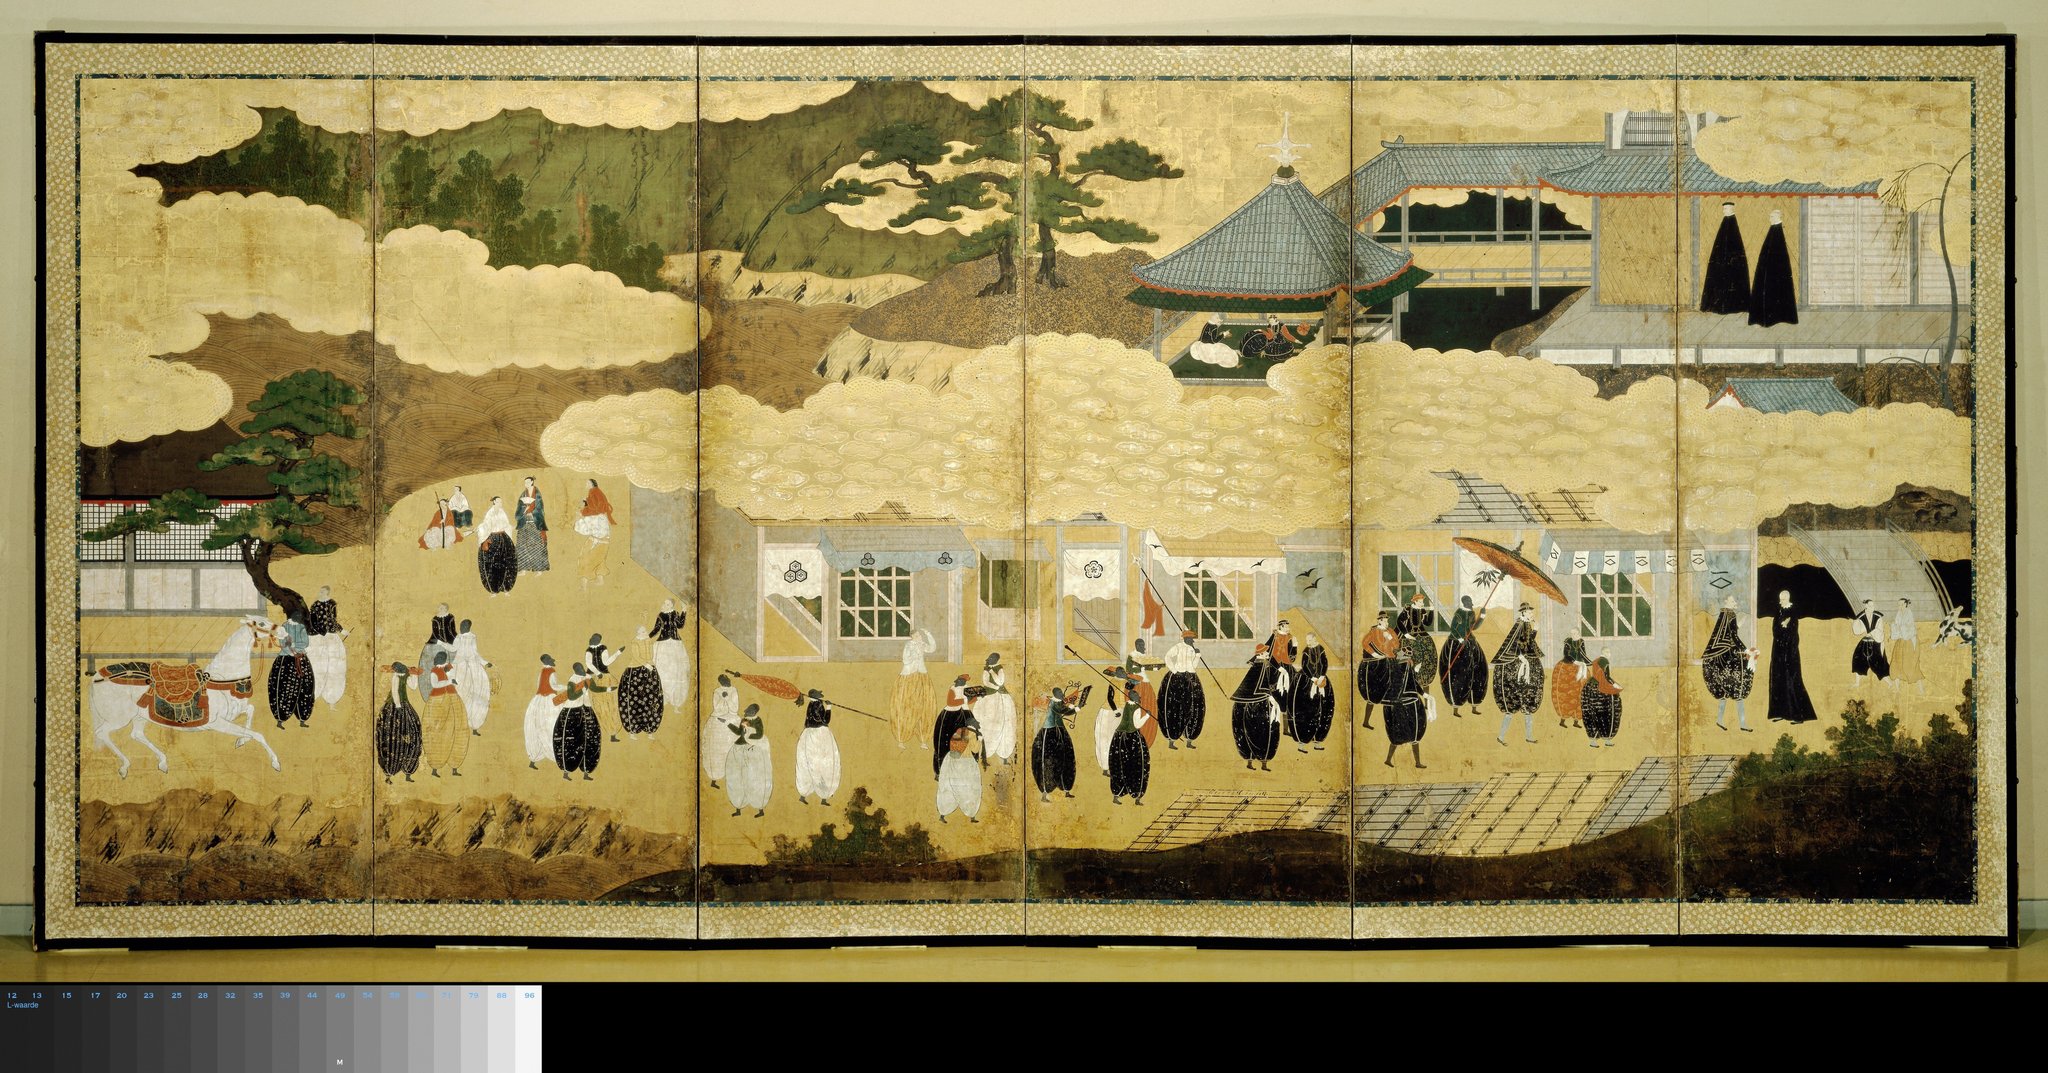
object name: screen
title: Folding Screen with the Arrival of a Portuguese Ship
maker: Anonymous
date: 1600-1625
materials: dye, paint, paper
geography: japan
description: The arrival of Portuguese ships in Nagasaki Harbour was quite an attraction in the early 17th century. This is what is taking place here, with the merchandise being unloaded at the left and the captain under a parasol at the right. Such screens were probably made for the Japanese merchant class, which made a fortune from the lucrative overseas trade with Portugal. They depict the foreign contacts in a nutshell for the Japanese spectator.